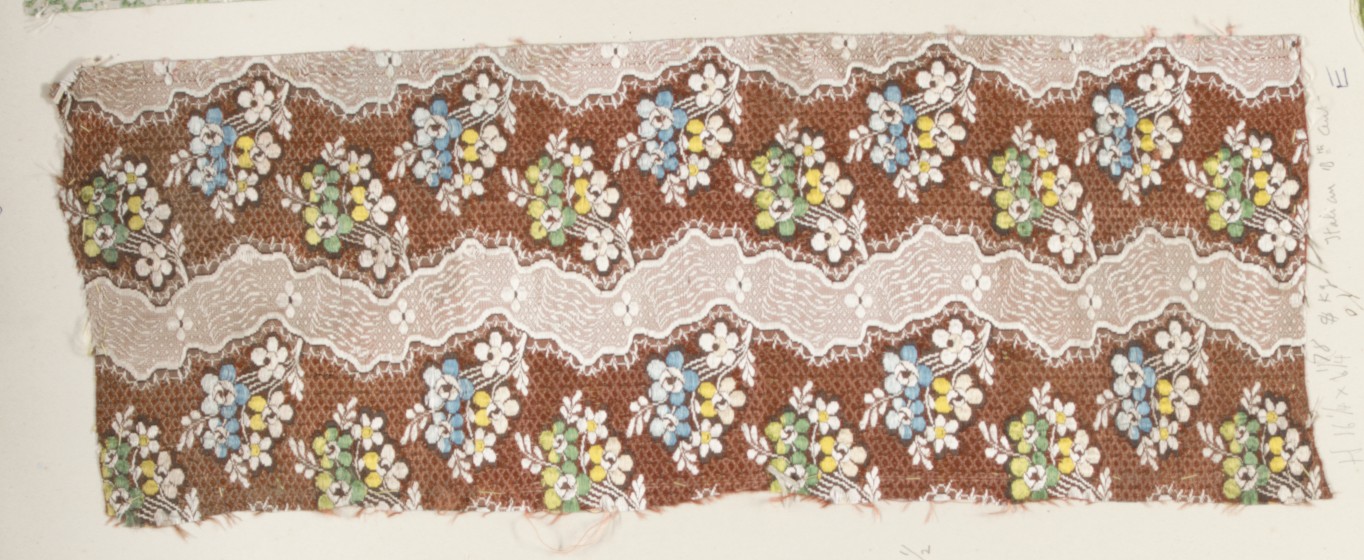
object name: fragment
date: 1701-1800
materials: silk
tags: flowers